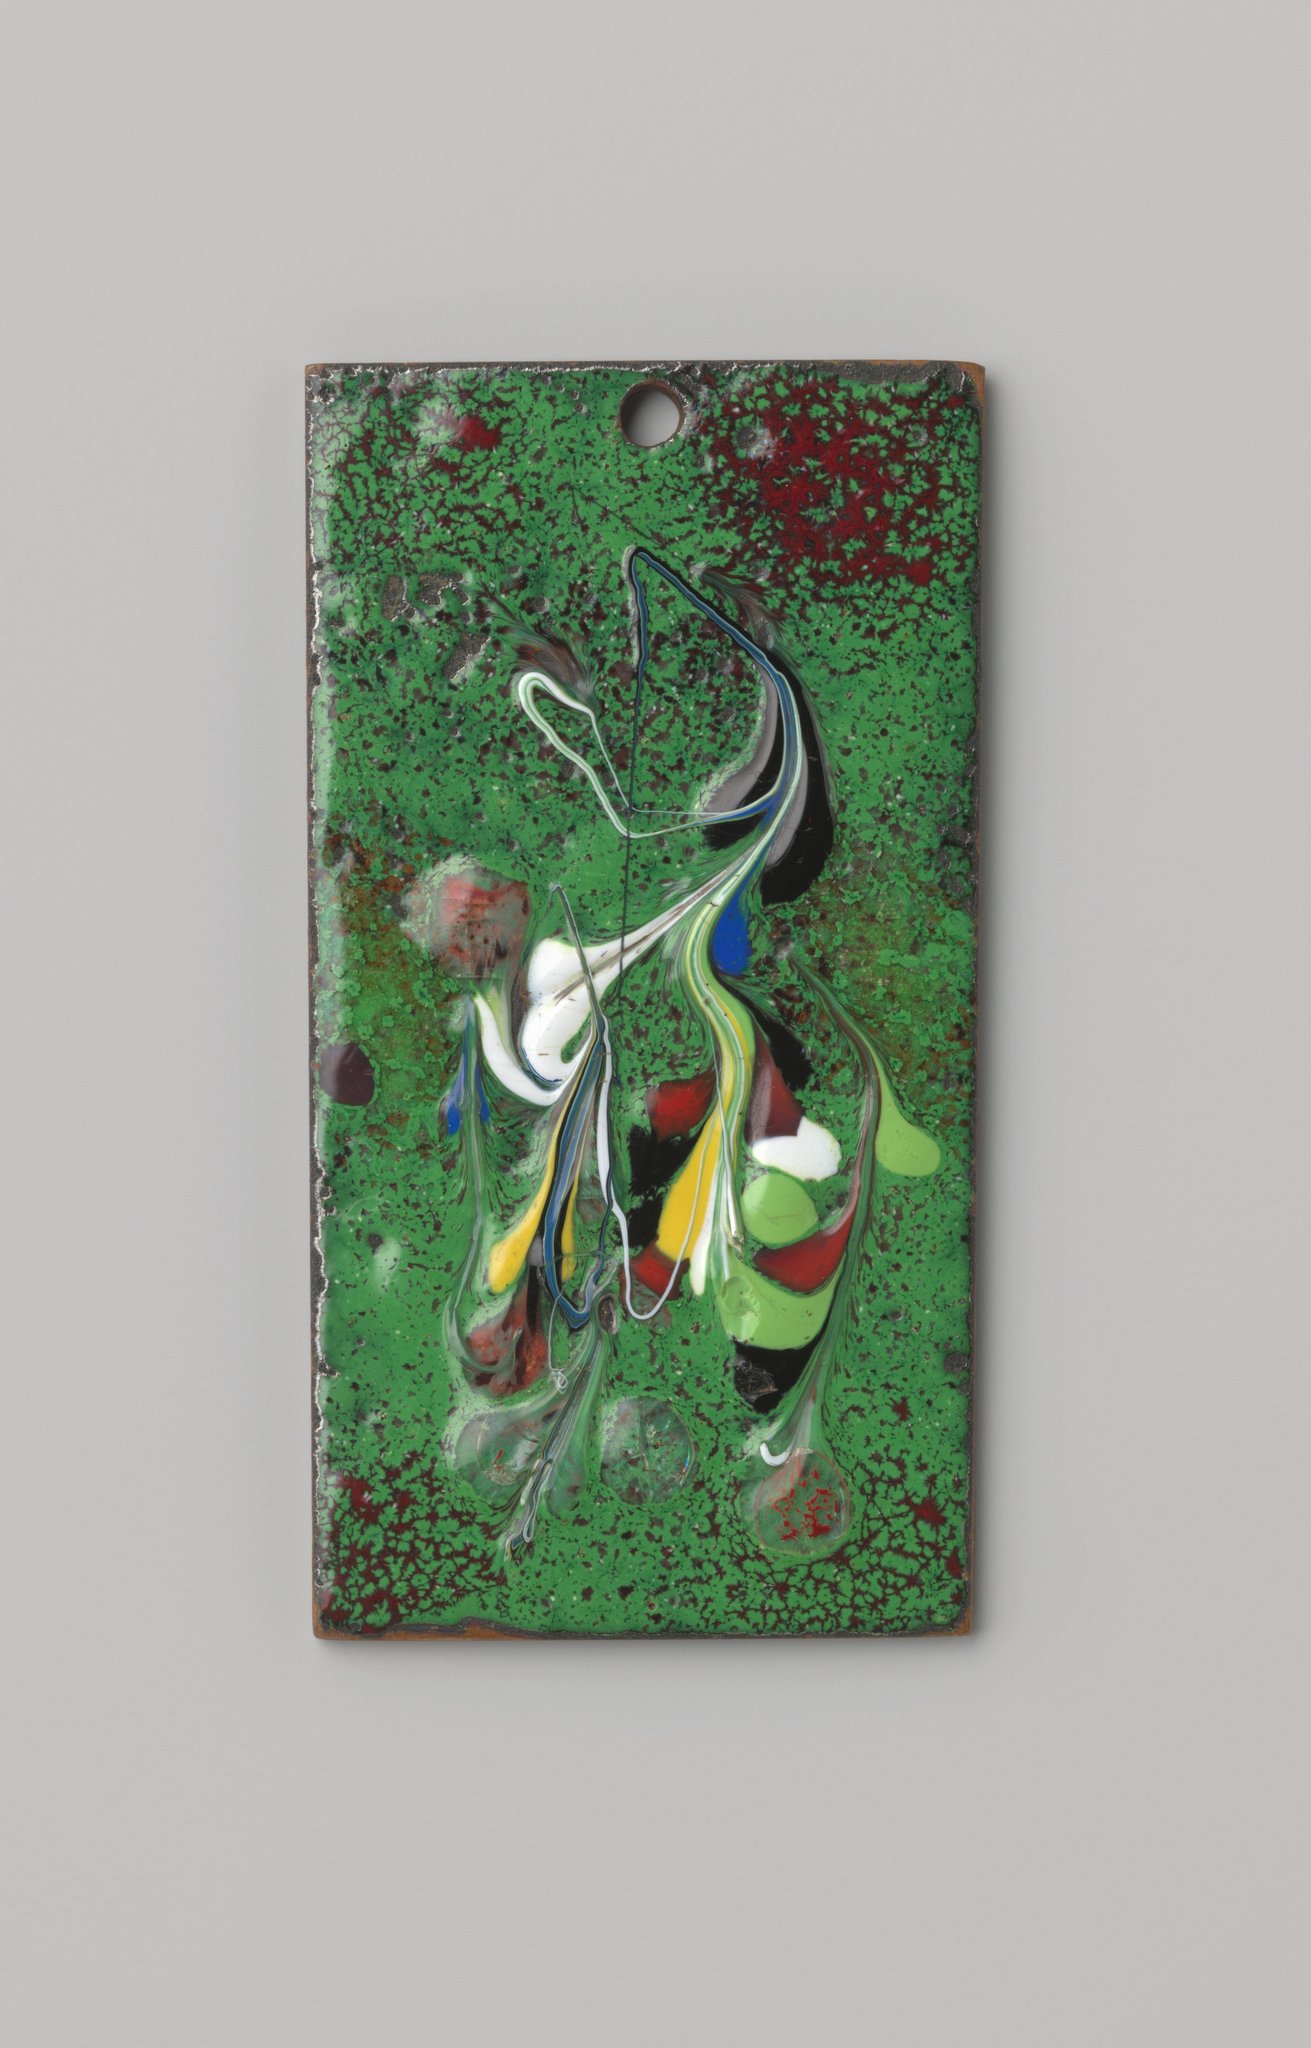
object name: plate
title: Rechthoekig plaatje van email op koper met abstracte decoratie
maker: Anonymous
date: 1950-1960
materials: copper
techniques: enameling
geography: netherlands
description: Rechthoekig plaatje van email op koper met een gat in het midden langs één van de korte zijden. De abstracte decoratie is in zwart, wit, groen, geel, rood en blauw op een groen met rood gevlekte achtergrond.